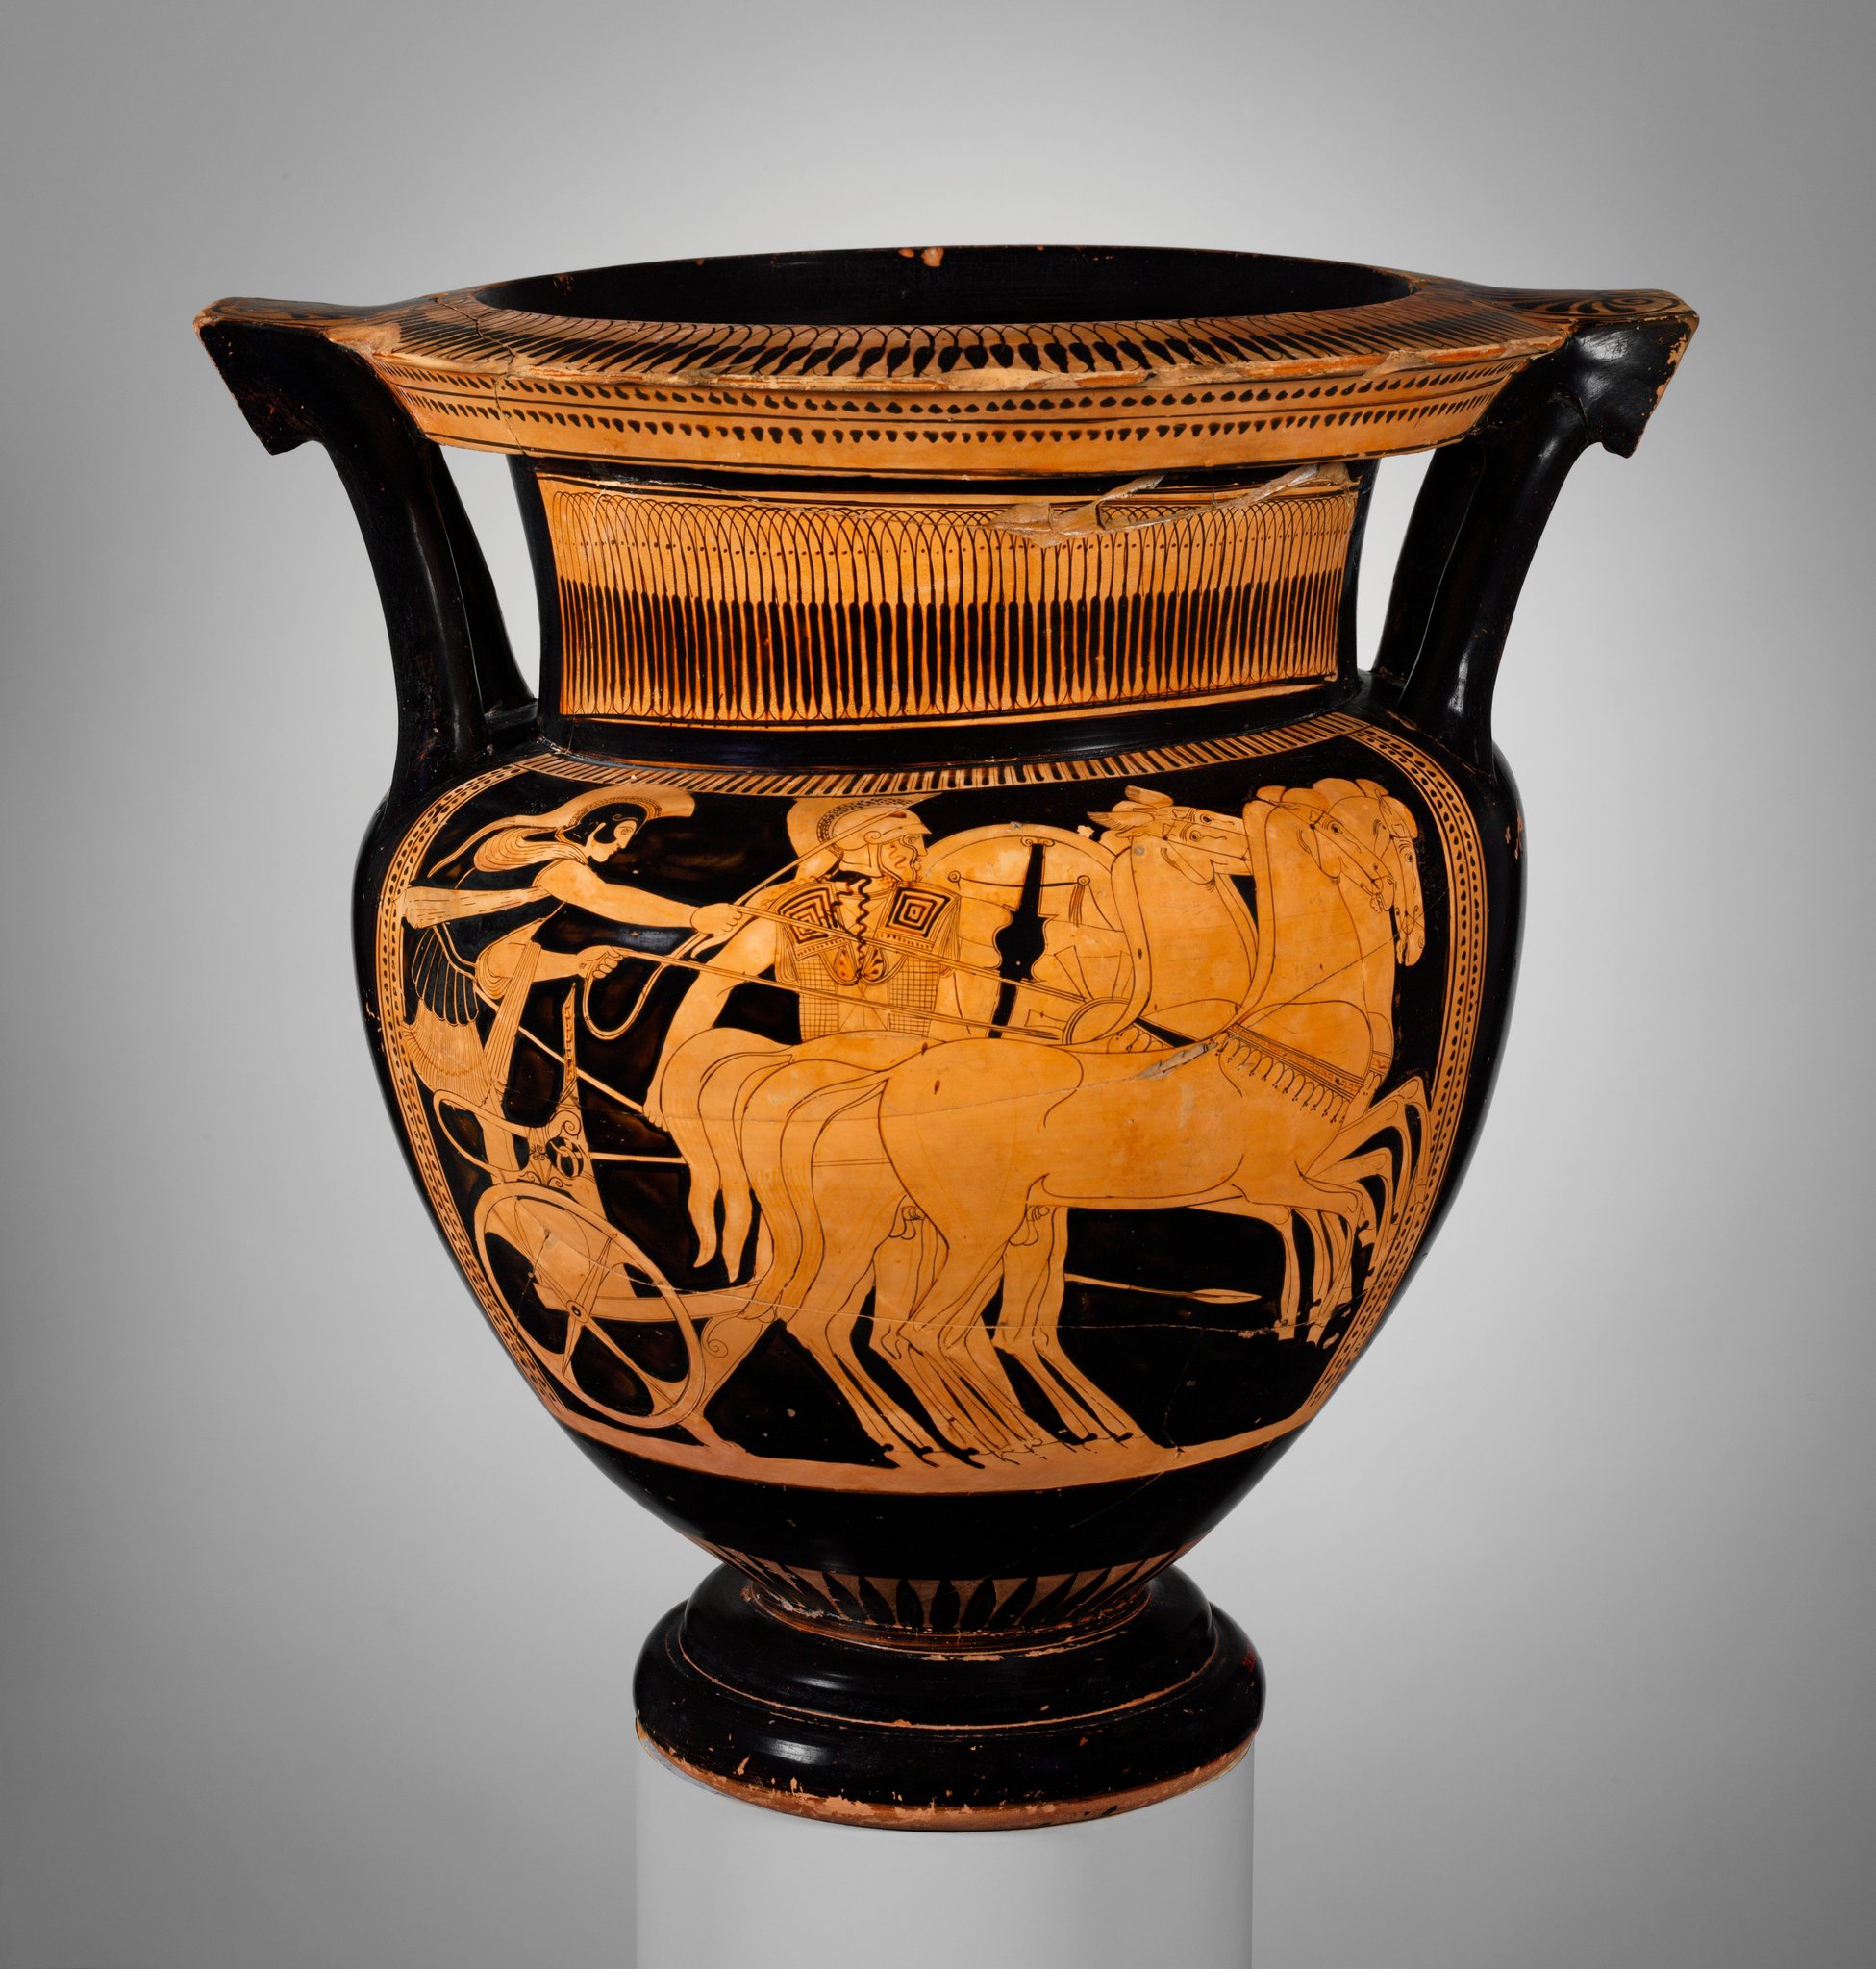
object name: column krater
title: Terracotta column-krater (bowl for mixing wine and water)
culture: greek, attic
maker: painter of bologna 228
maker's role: artist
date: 460 BCE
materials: terracotta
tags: dionysus,maenads,horses,chariots